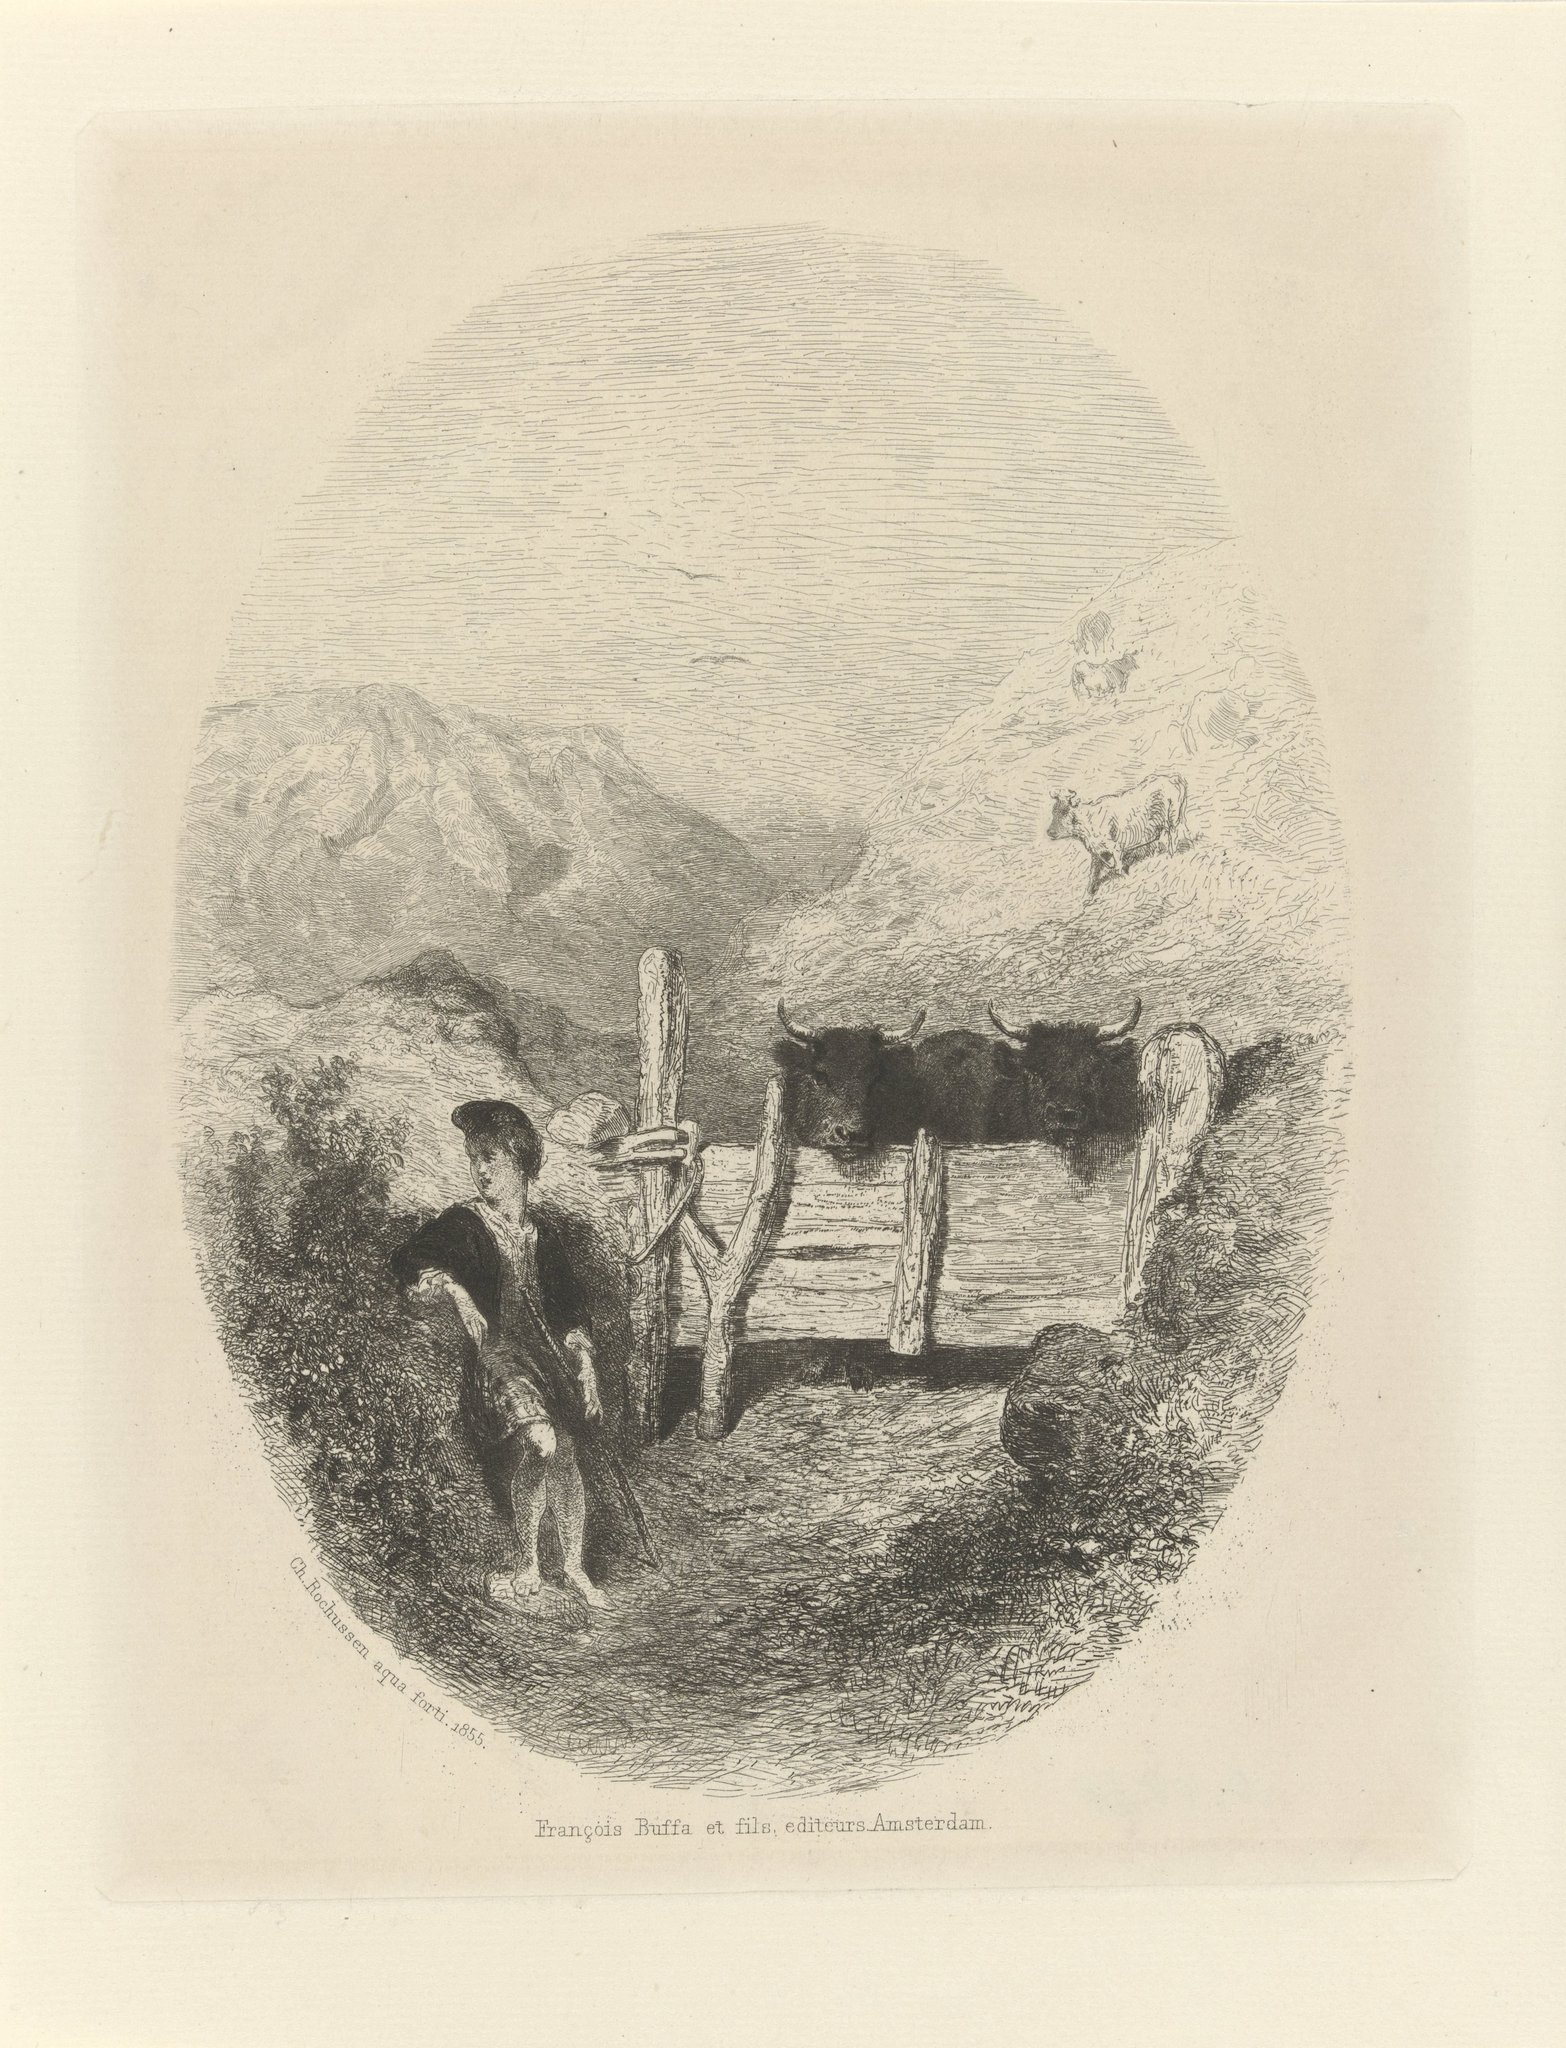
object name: print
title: Schotse herder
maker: charles rochussen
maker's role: draughtsman, painter, print maker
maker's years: 1814-1894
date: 1855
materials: paper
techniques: drypoint, etching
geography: amsterdam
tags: cow, herding, herdsman, herdswoman, shepherd, shepherdess, cowherd, etc., (high) hill - hh - ideal landscapes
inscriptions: collector's mark: Lugt 2228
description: In een heuvelachtig landschap staat een herder bij een hek waar ook twee runderen bij staan. Op de achtergrond op een heuvel bevinden zich enkele koeien.